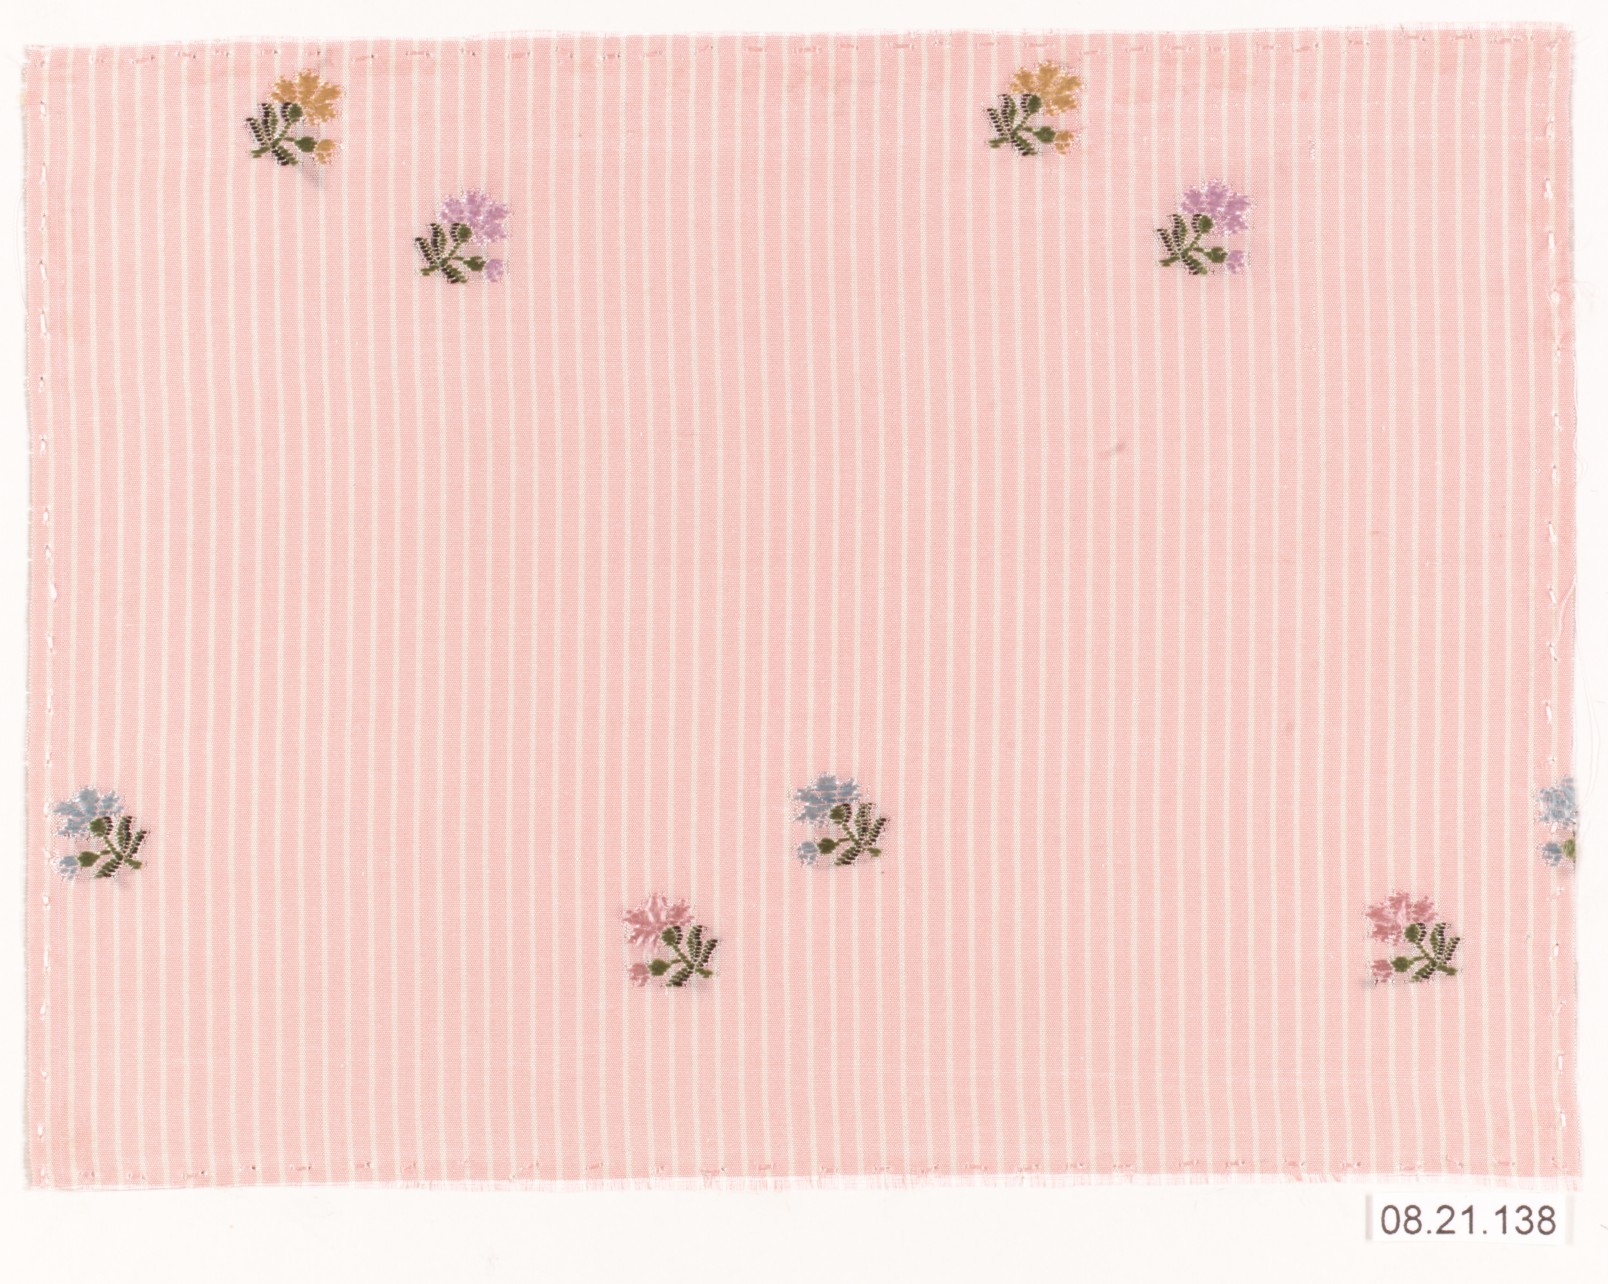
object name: textile sample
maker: Anonymous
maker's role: designer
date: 1900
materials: silk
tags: flowers